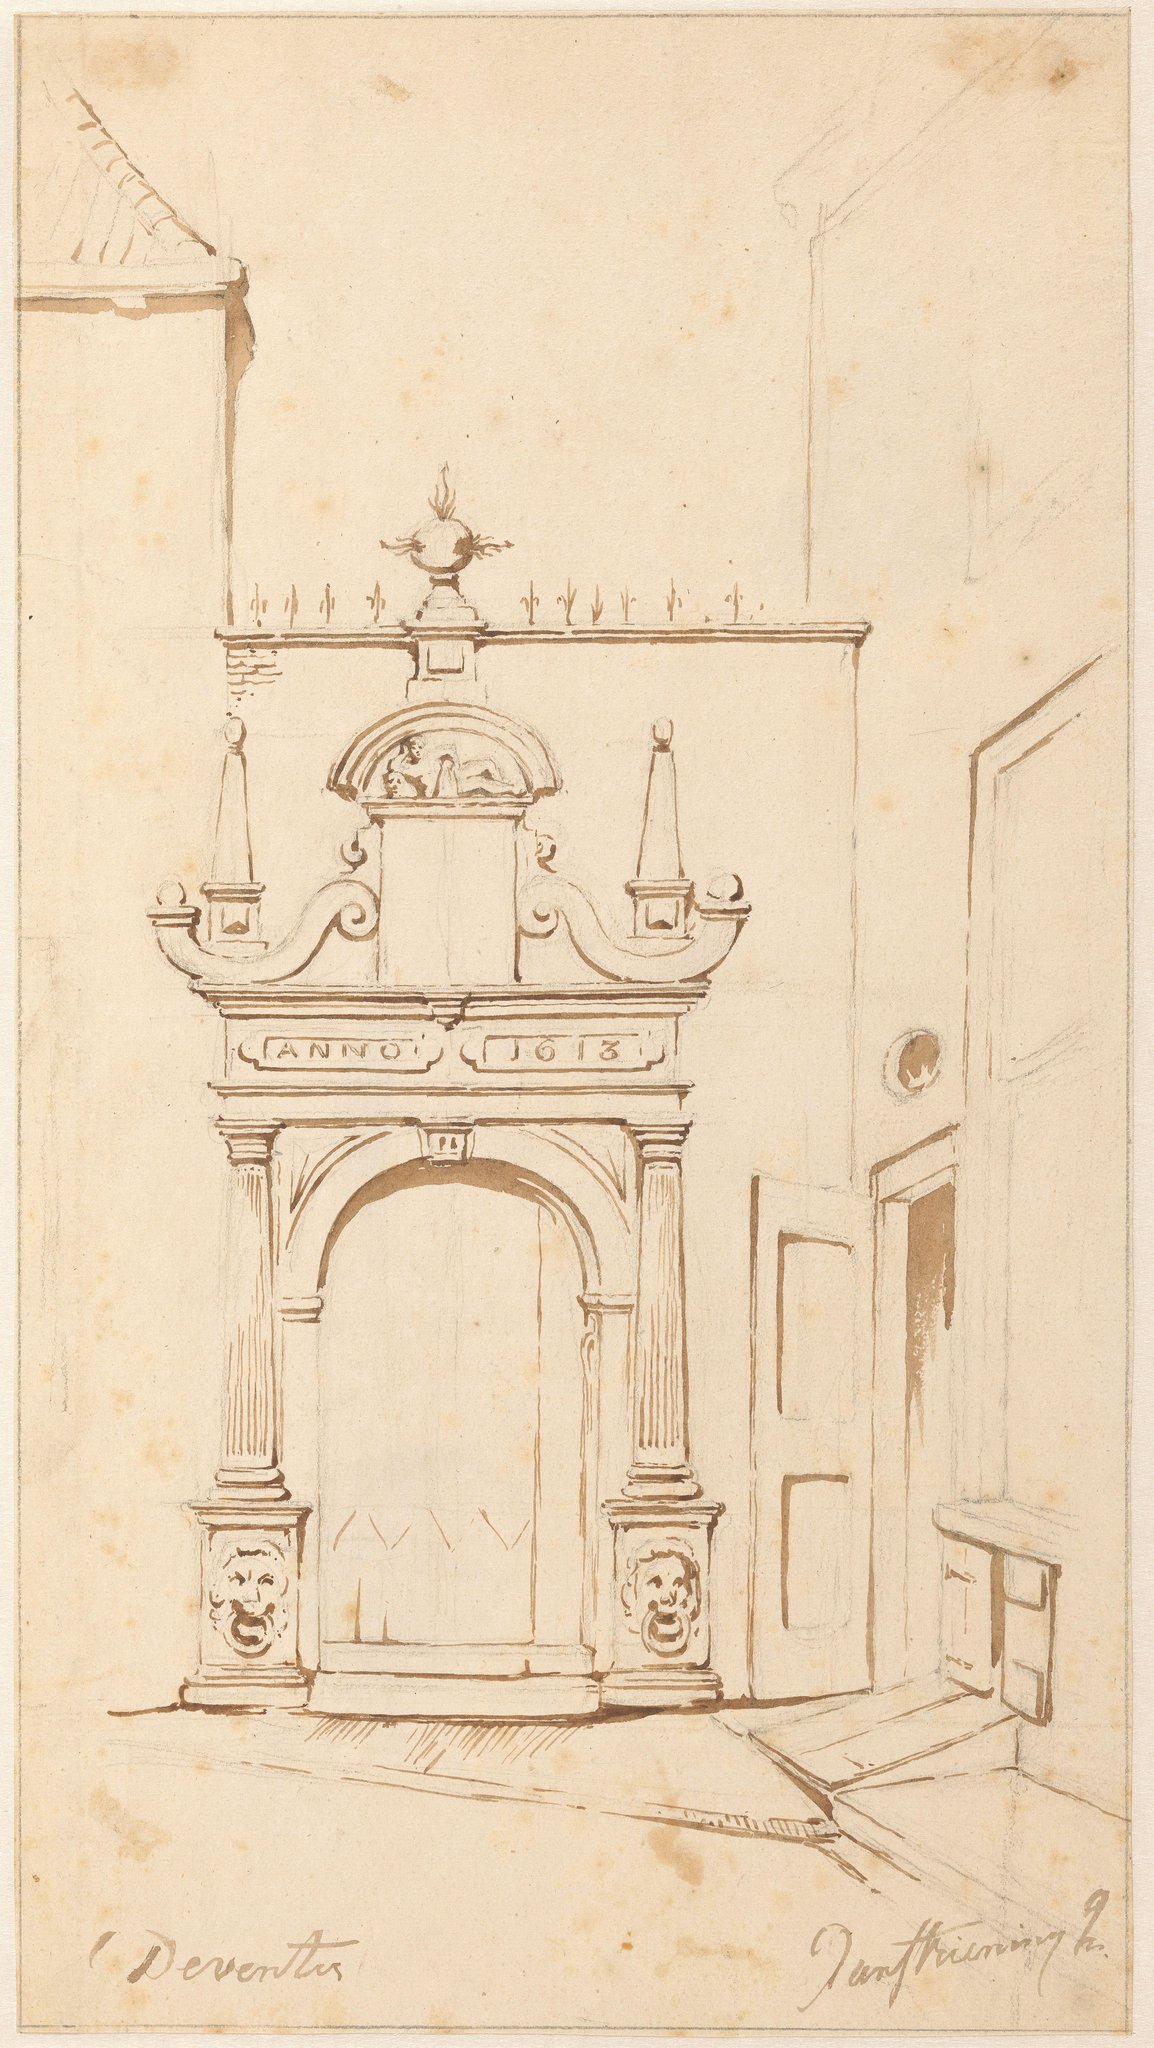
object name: drawing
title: Poort te Deventer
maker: jan striening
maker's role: draughtsman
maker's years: 1827-1903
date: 1837-1903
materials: paper, pencil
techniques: brush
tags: switchback, scenic railway, deventer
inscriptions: annotation: ‘anno 1613’